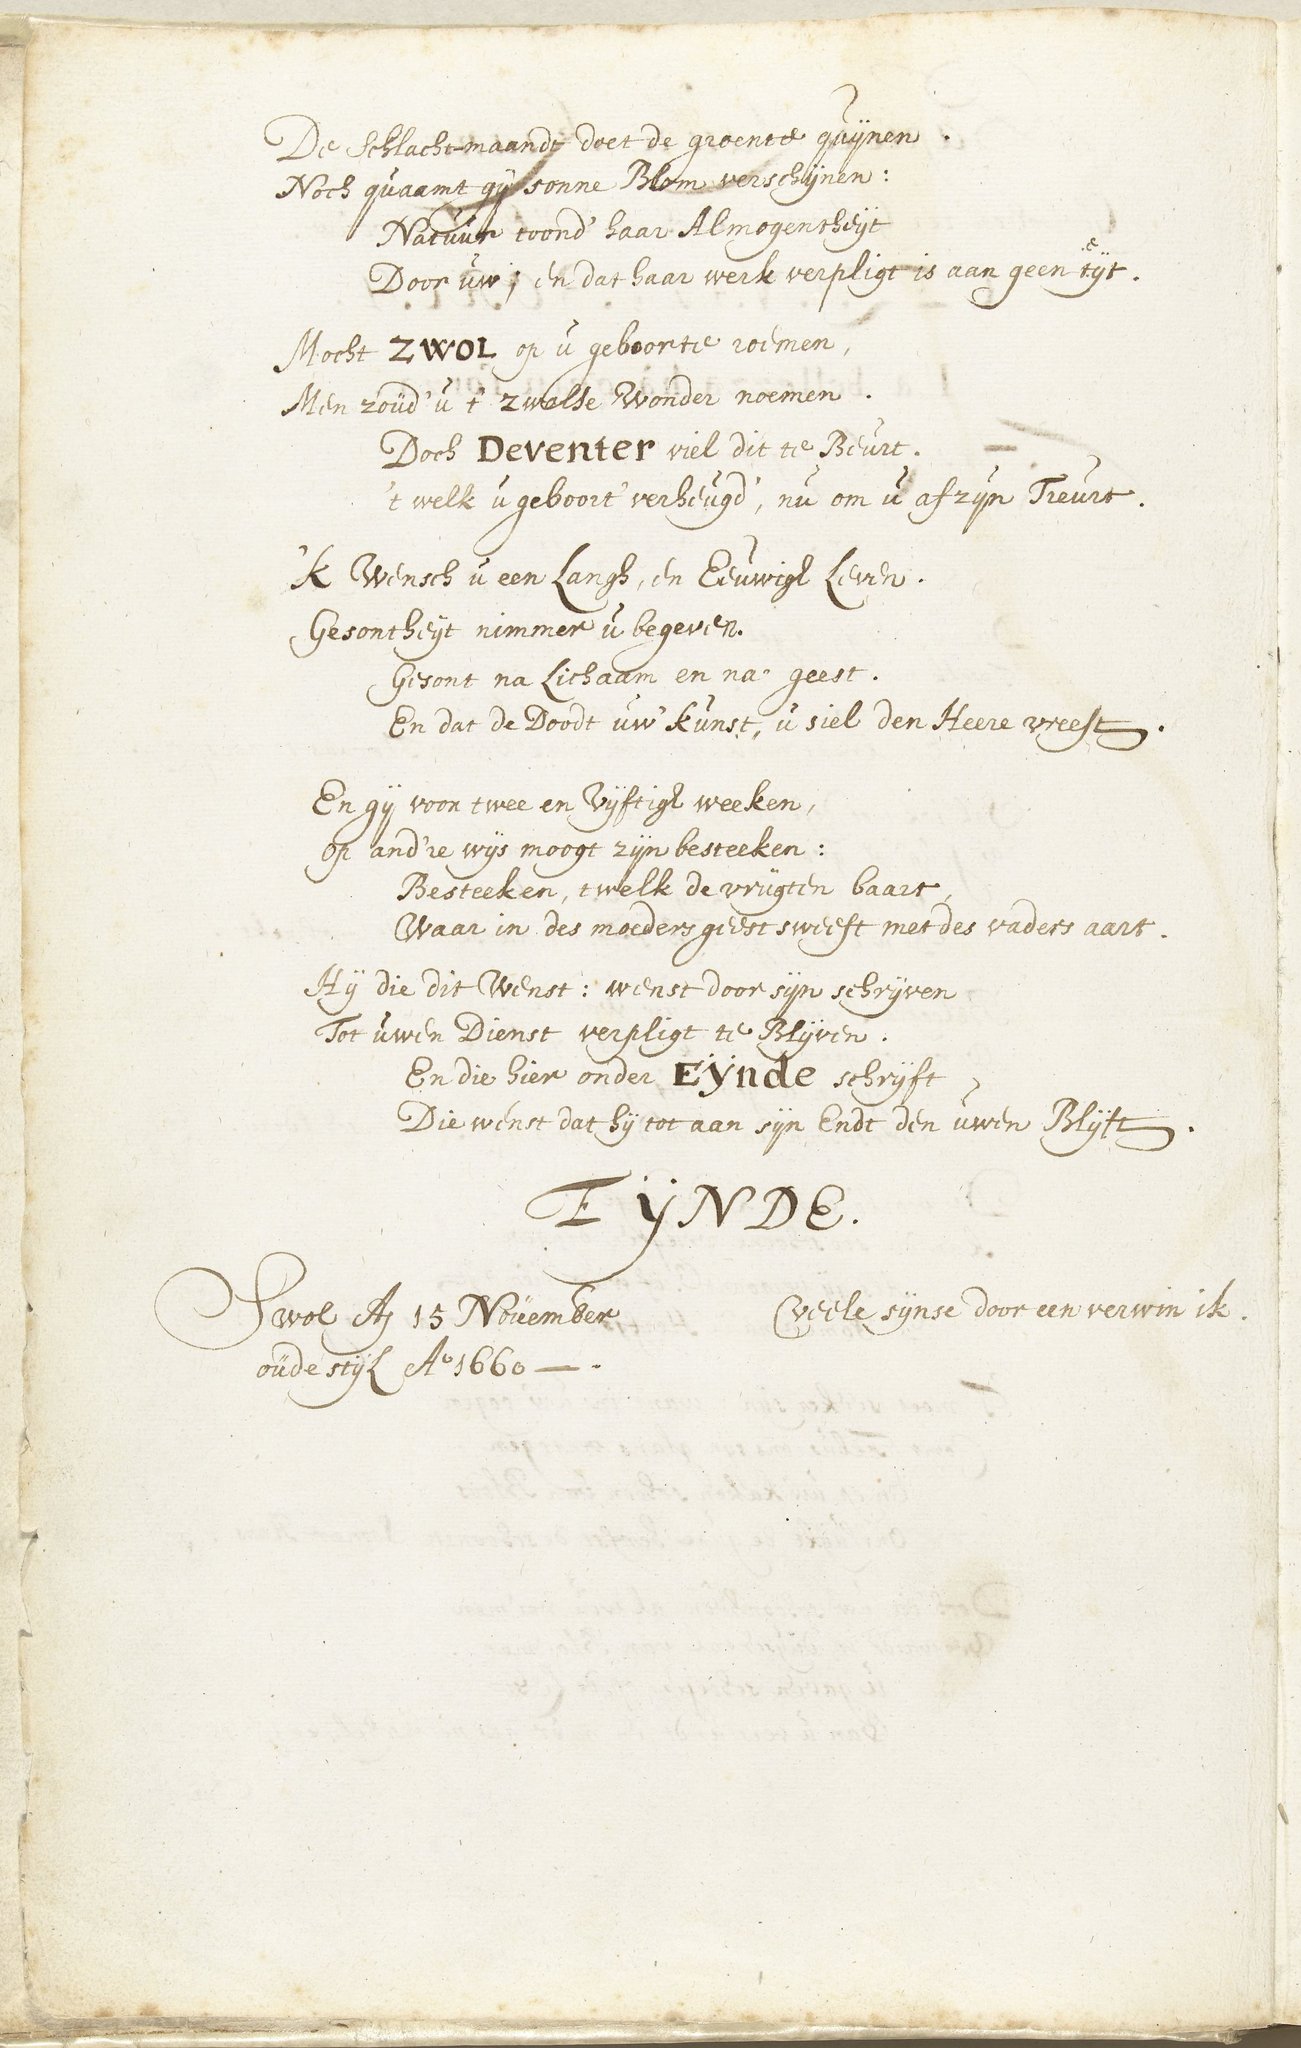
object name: poem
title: Gelegenheidsgedicht voor Gesina ter Borchs verjaardag (deel 2)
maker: henrik jordis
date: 1660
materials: ink, paper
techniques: calligraphy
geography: zwolle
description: Vervolg van het gelegenheidsgedicht op de voorzijde van het blad, op de melodie van La bellezza ha' gran forza.